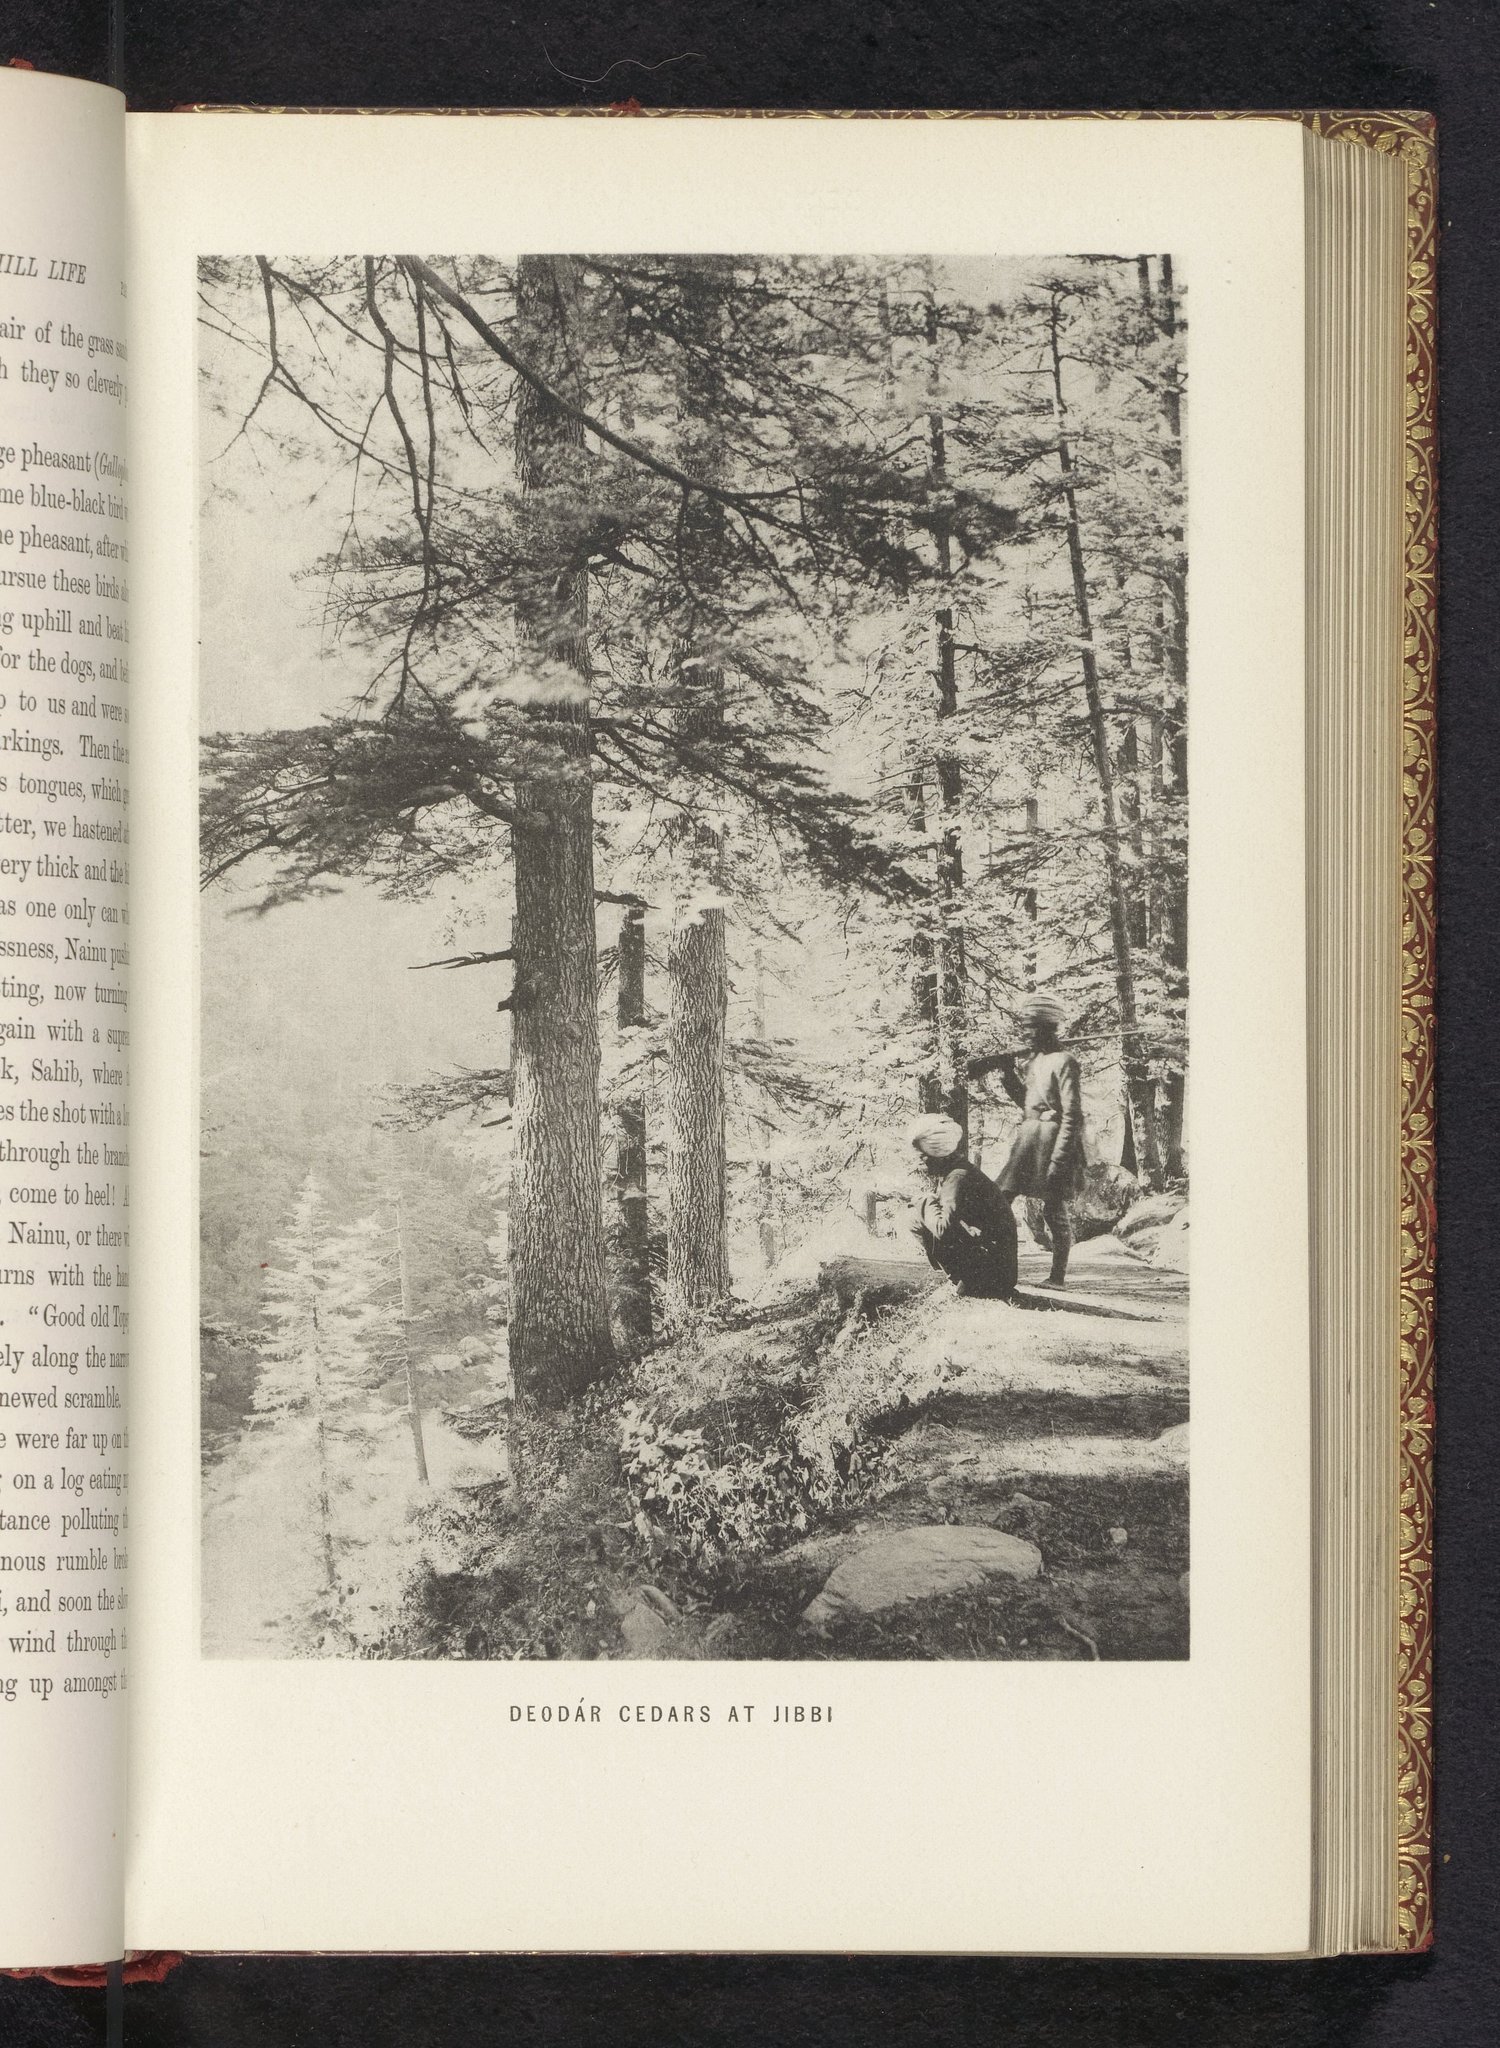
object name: page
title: Deodar cedars in the Jibhi valley, Himachal Pradesh, India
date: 1890-1895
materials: paper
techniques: photograph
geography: himachal pradesh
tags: dale, valley, trees: cedar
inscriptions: caption: ‘DEODÁR CEDARS AT JIBBI’